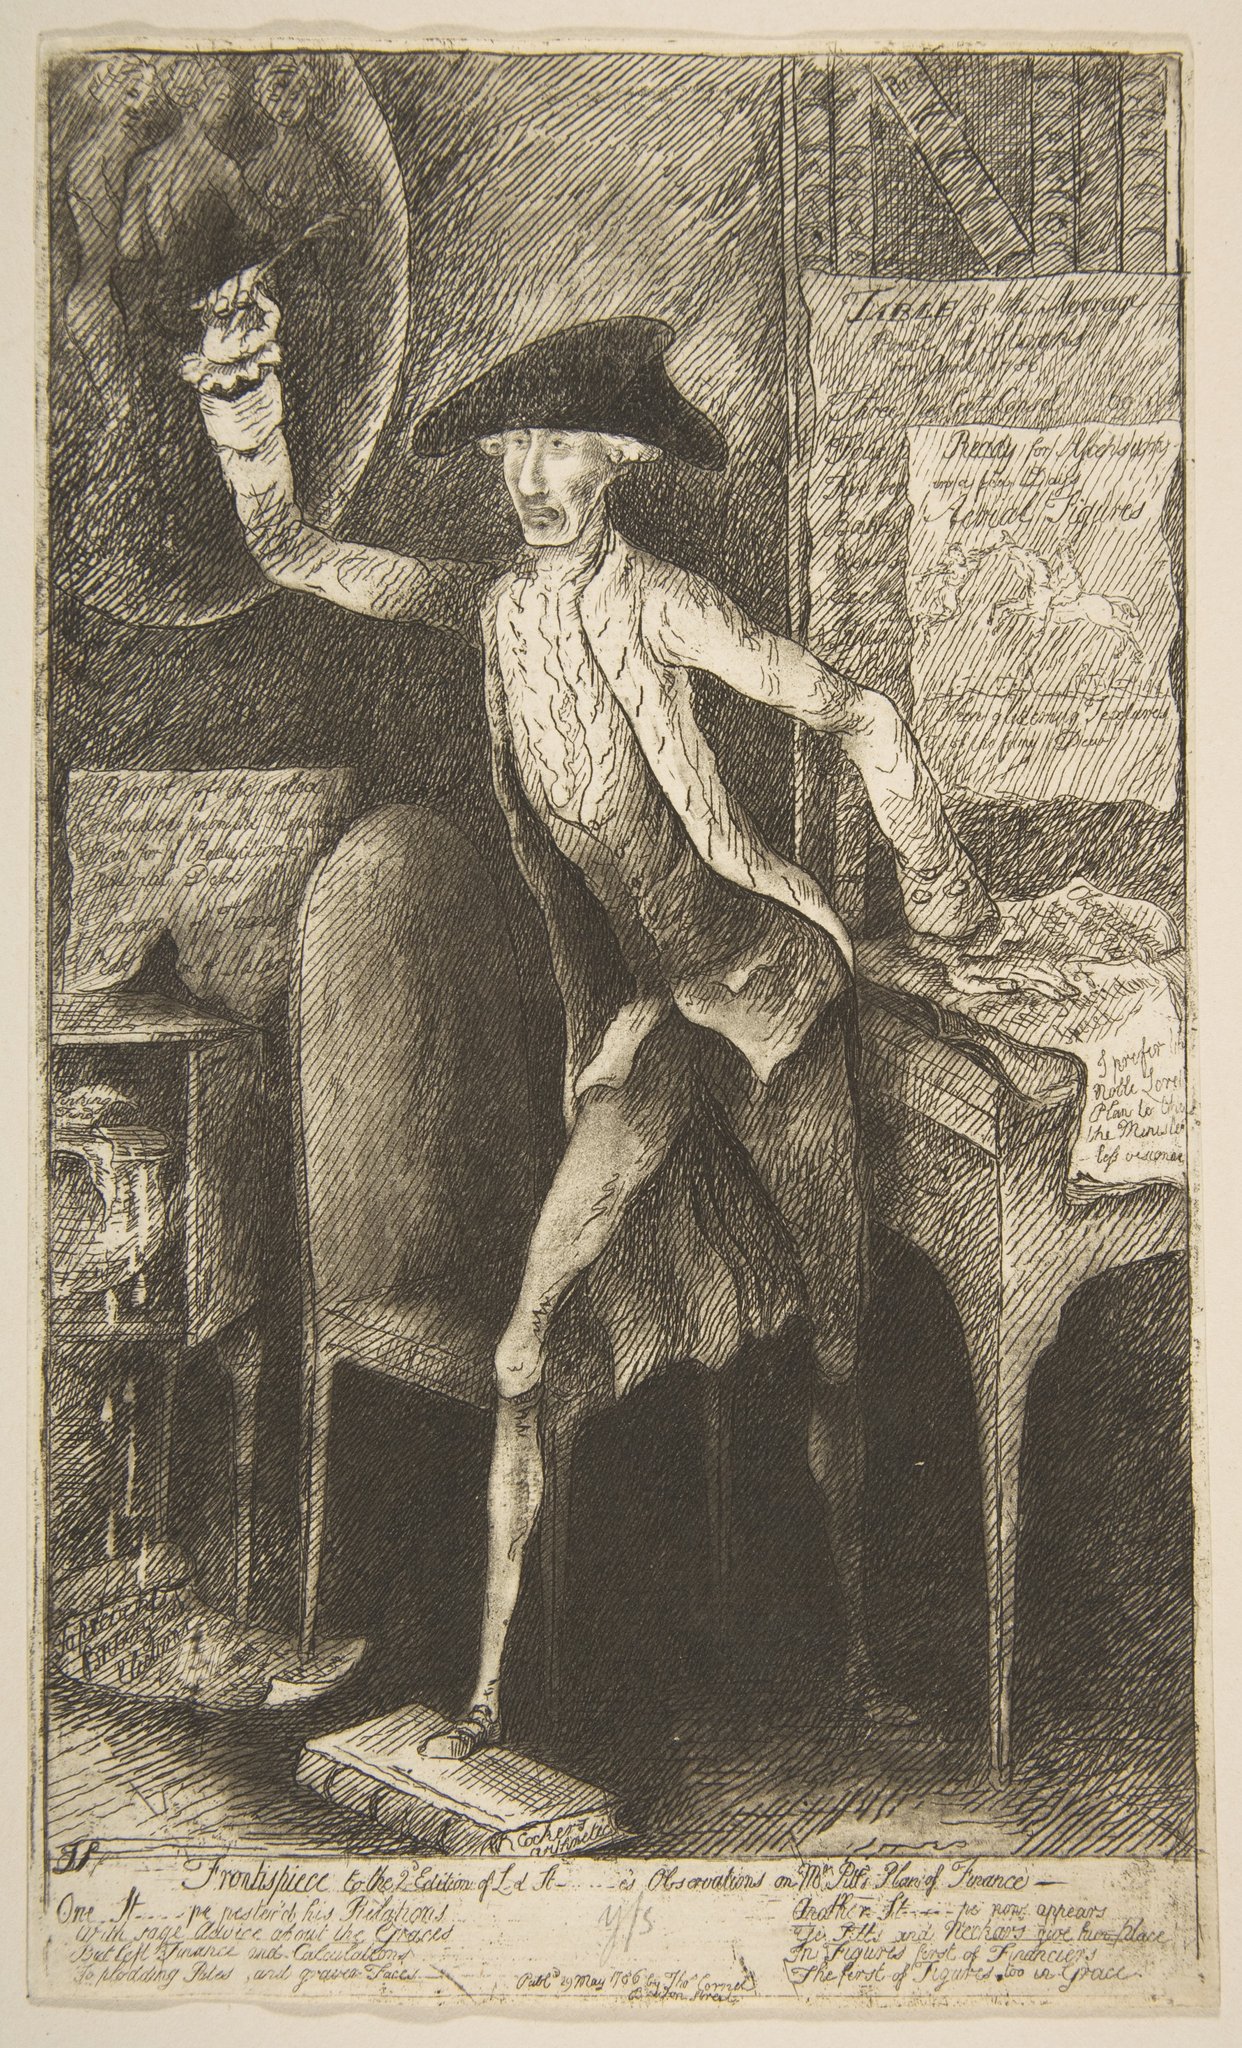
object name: print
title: Frontispiece to the 2nd Edition of Lord St[anhop]e's Observations on Mr. Pitt's Plan of Finance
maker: james sayers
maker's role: artist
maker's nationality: british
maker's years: 1748-1823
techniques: aquatint, etching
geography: england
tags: satire,men,politics